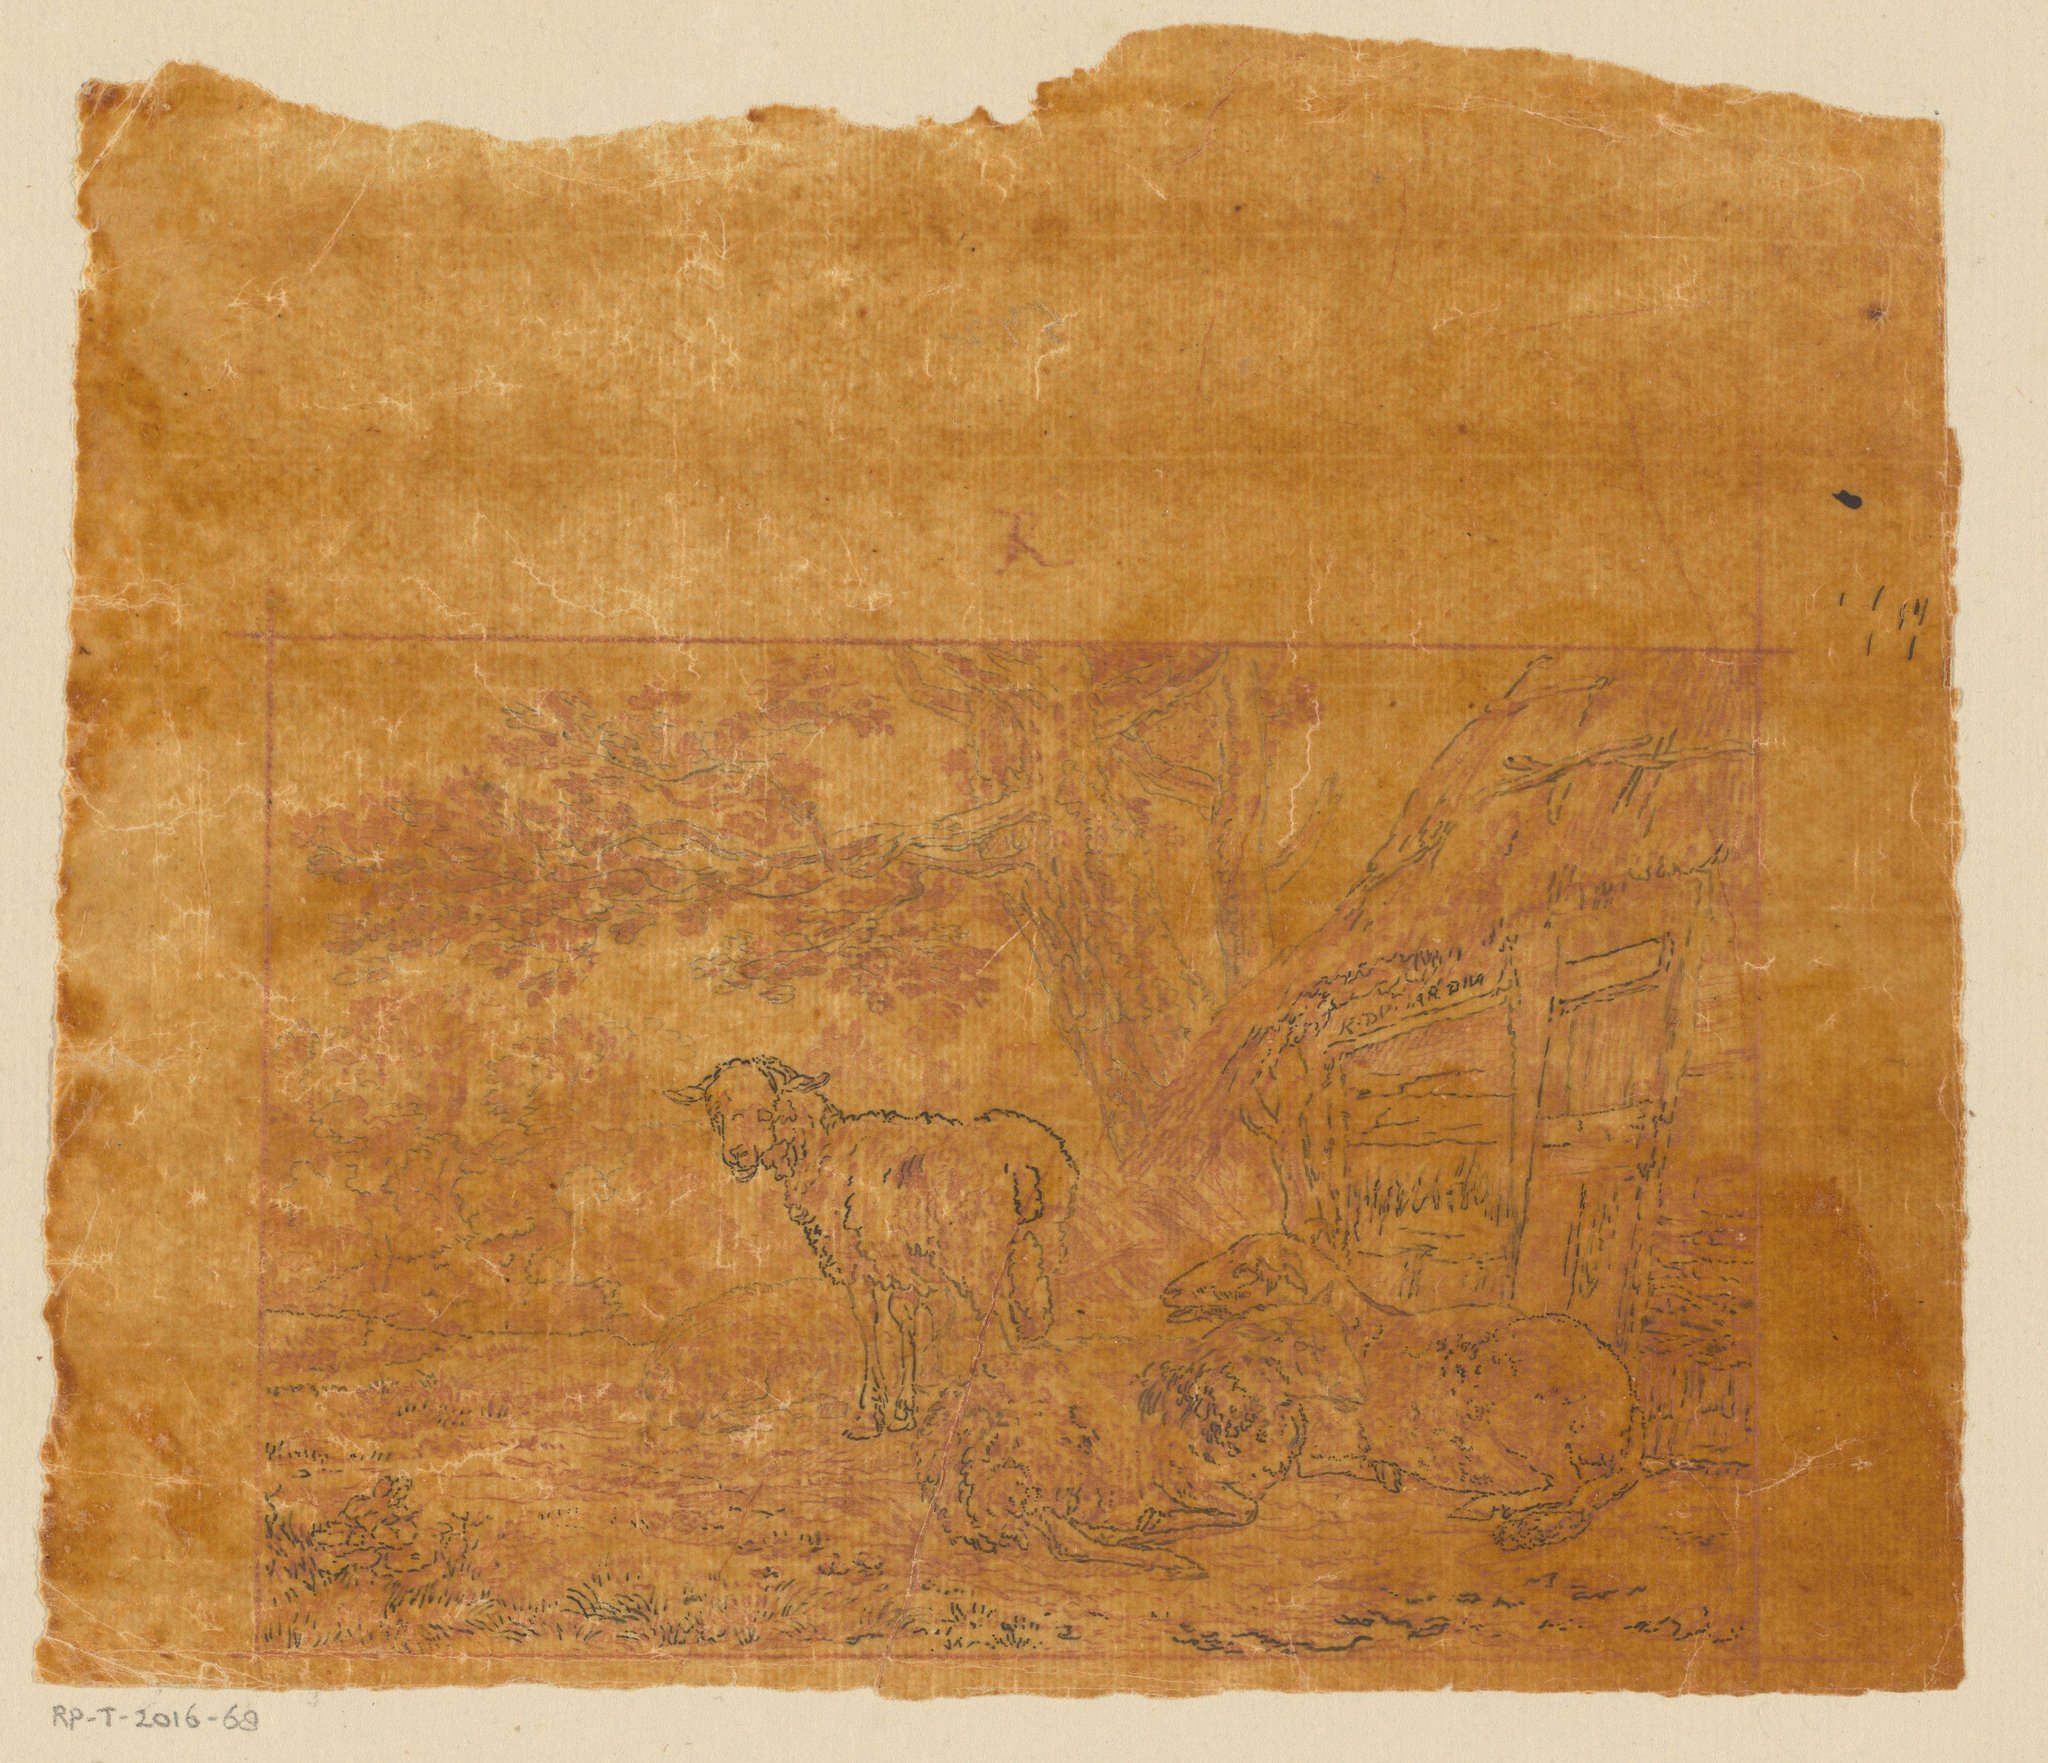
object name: drawing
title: Schaapskooi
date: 1781-1787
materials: chalk, ink, paper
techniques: brush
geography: amsterdam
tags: sheep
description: Vier schapen bij de geopende schaapskooi. De calque ligt los in een album, zie blad 44.